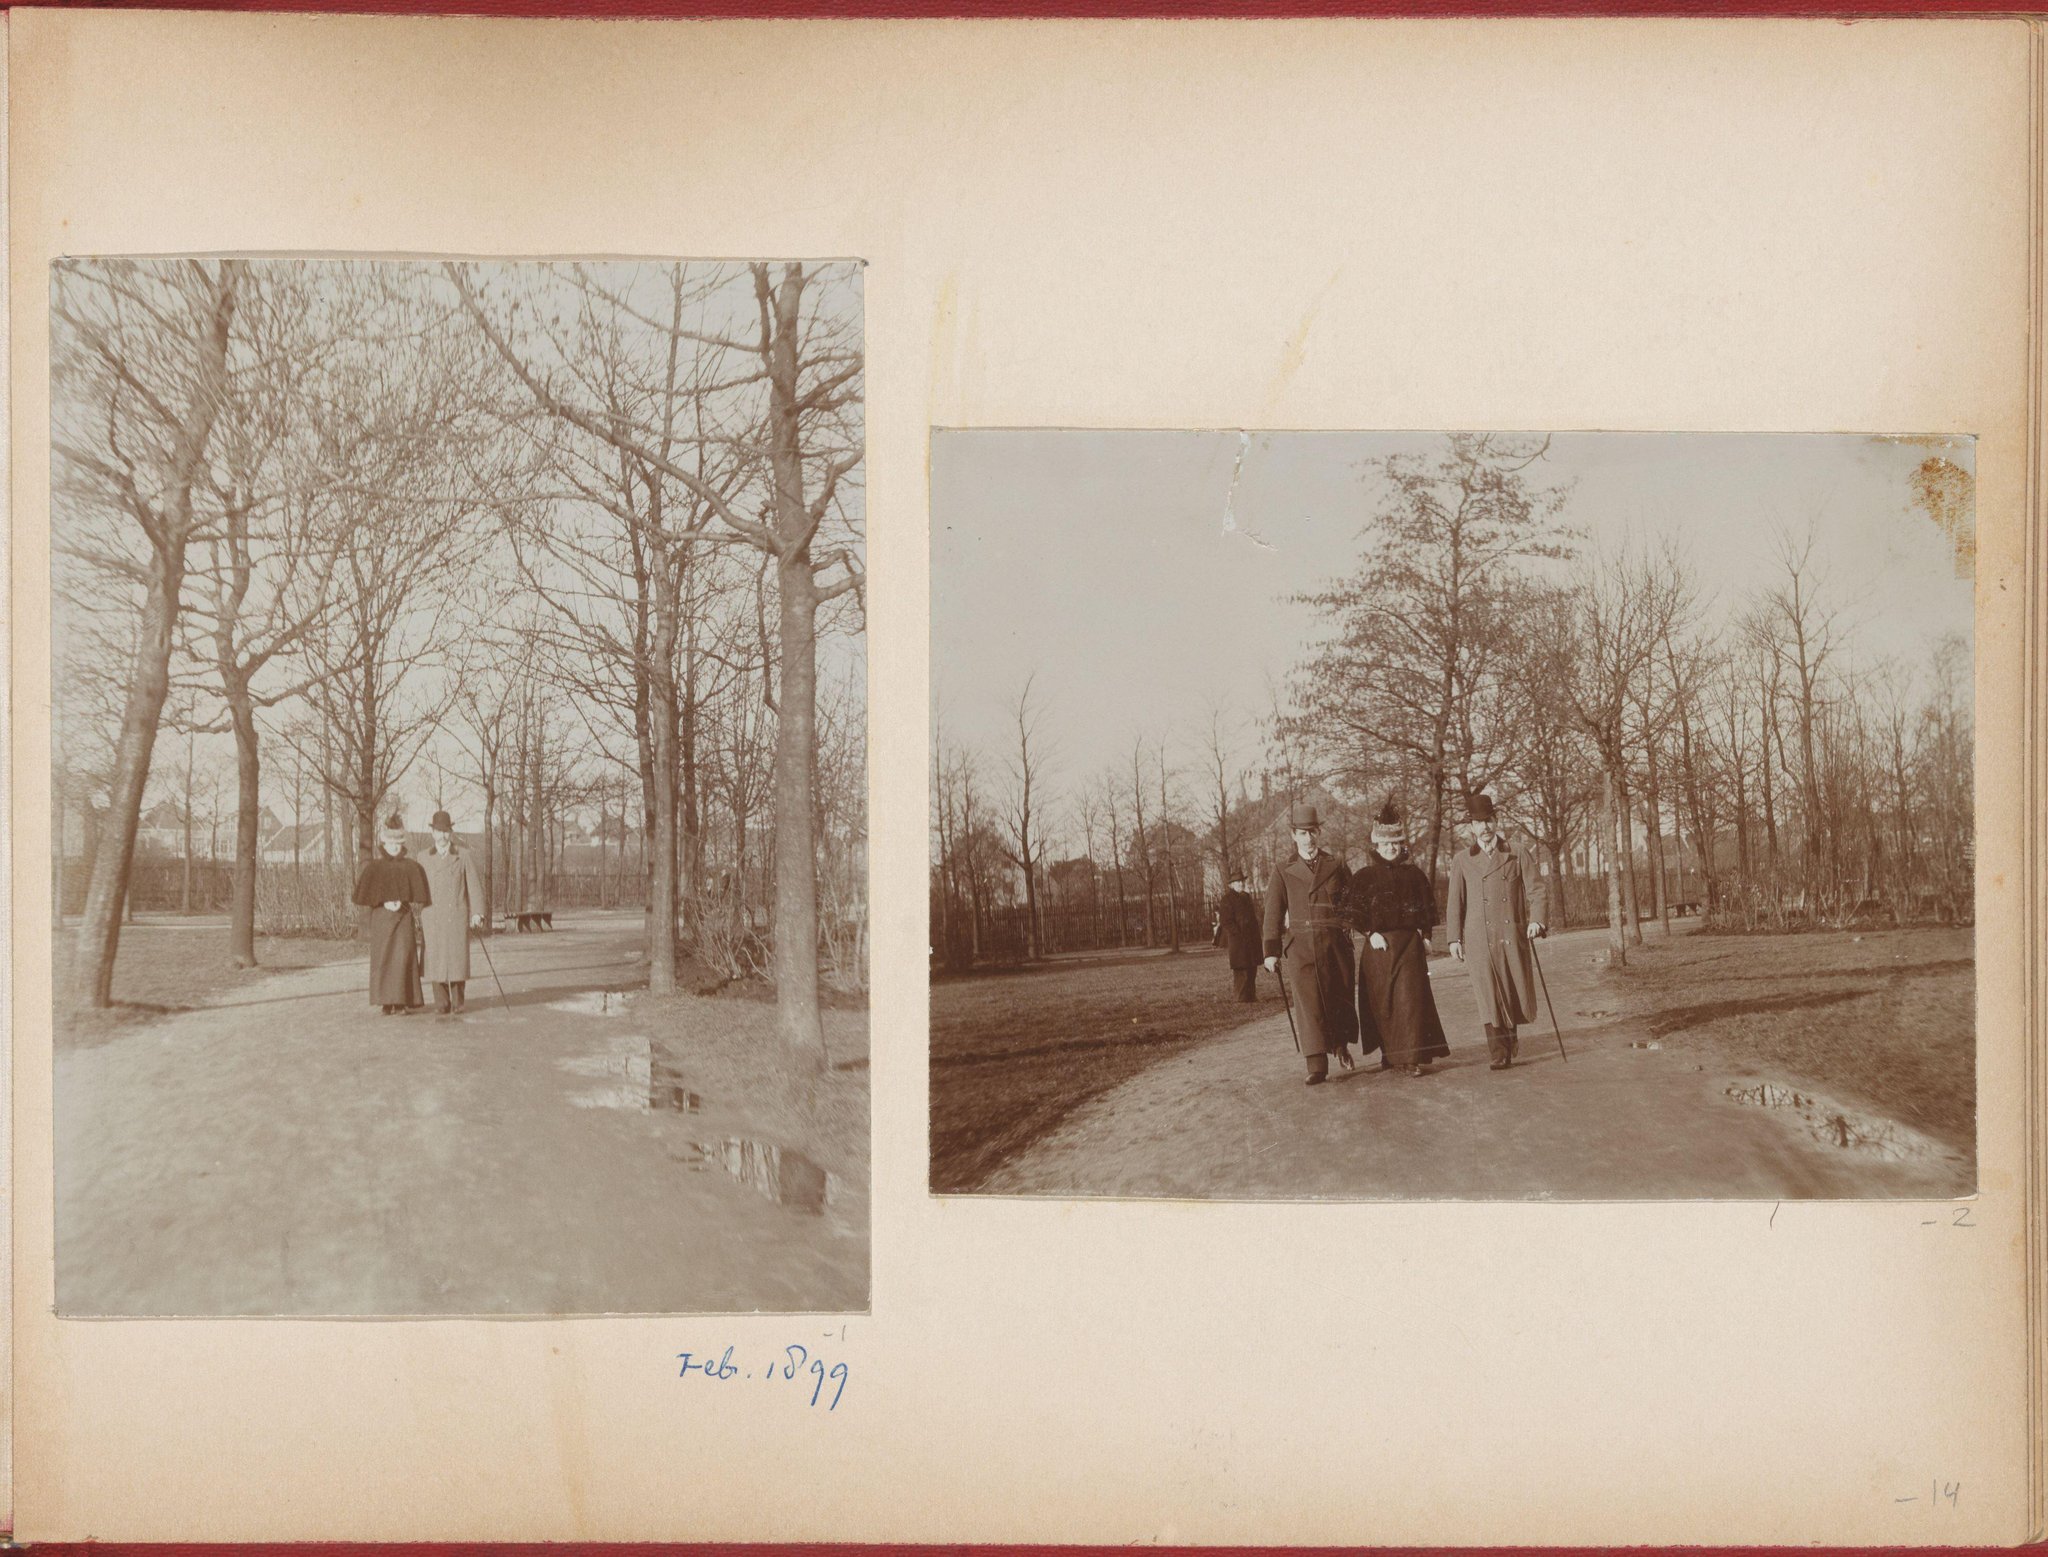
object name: photograph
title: Het jonge paar uit het fotoverhaal met een andere jonge man wandelend in een Amsterdams park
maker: gerard aalbersberg (us)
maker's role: amateurfotograaf, arts, chirurg, gynaecoloog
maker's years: 1870-1934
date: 1802-1899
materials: paper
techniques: collodion silver print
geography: amsterdam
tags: amsterdam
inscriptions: date: ‘Feb. 1899’